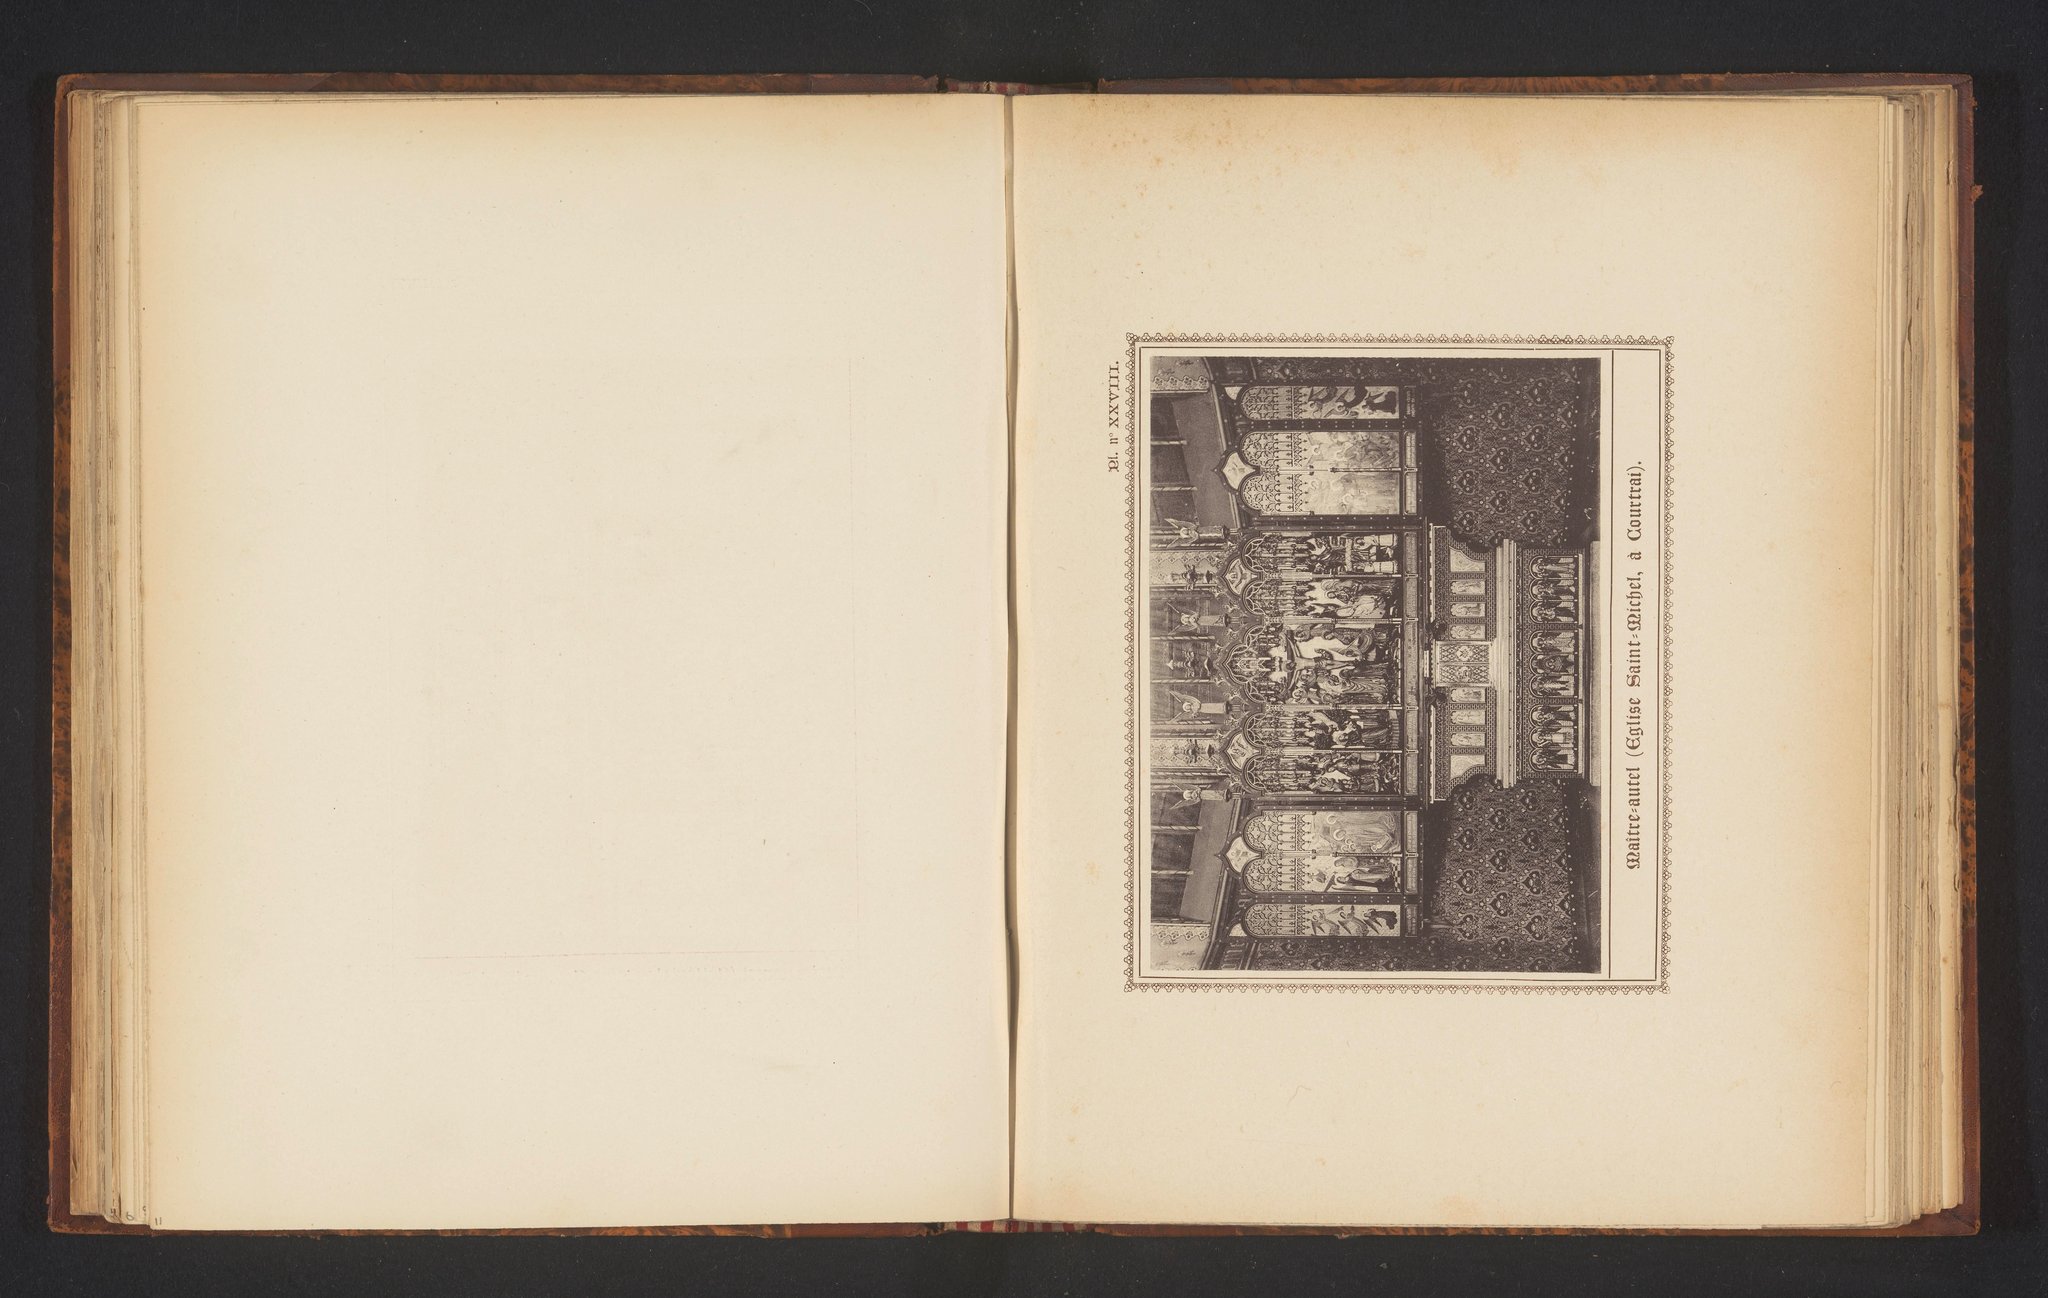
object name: page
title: Maître-Autel (Eglise Saint-Michel, à Coutrai)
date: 1891-1896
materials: paper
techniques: photograph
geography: kortrijk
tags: altar with altar-piece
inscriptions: number: ‘Pl. no XXVIII.’